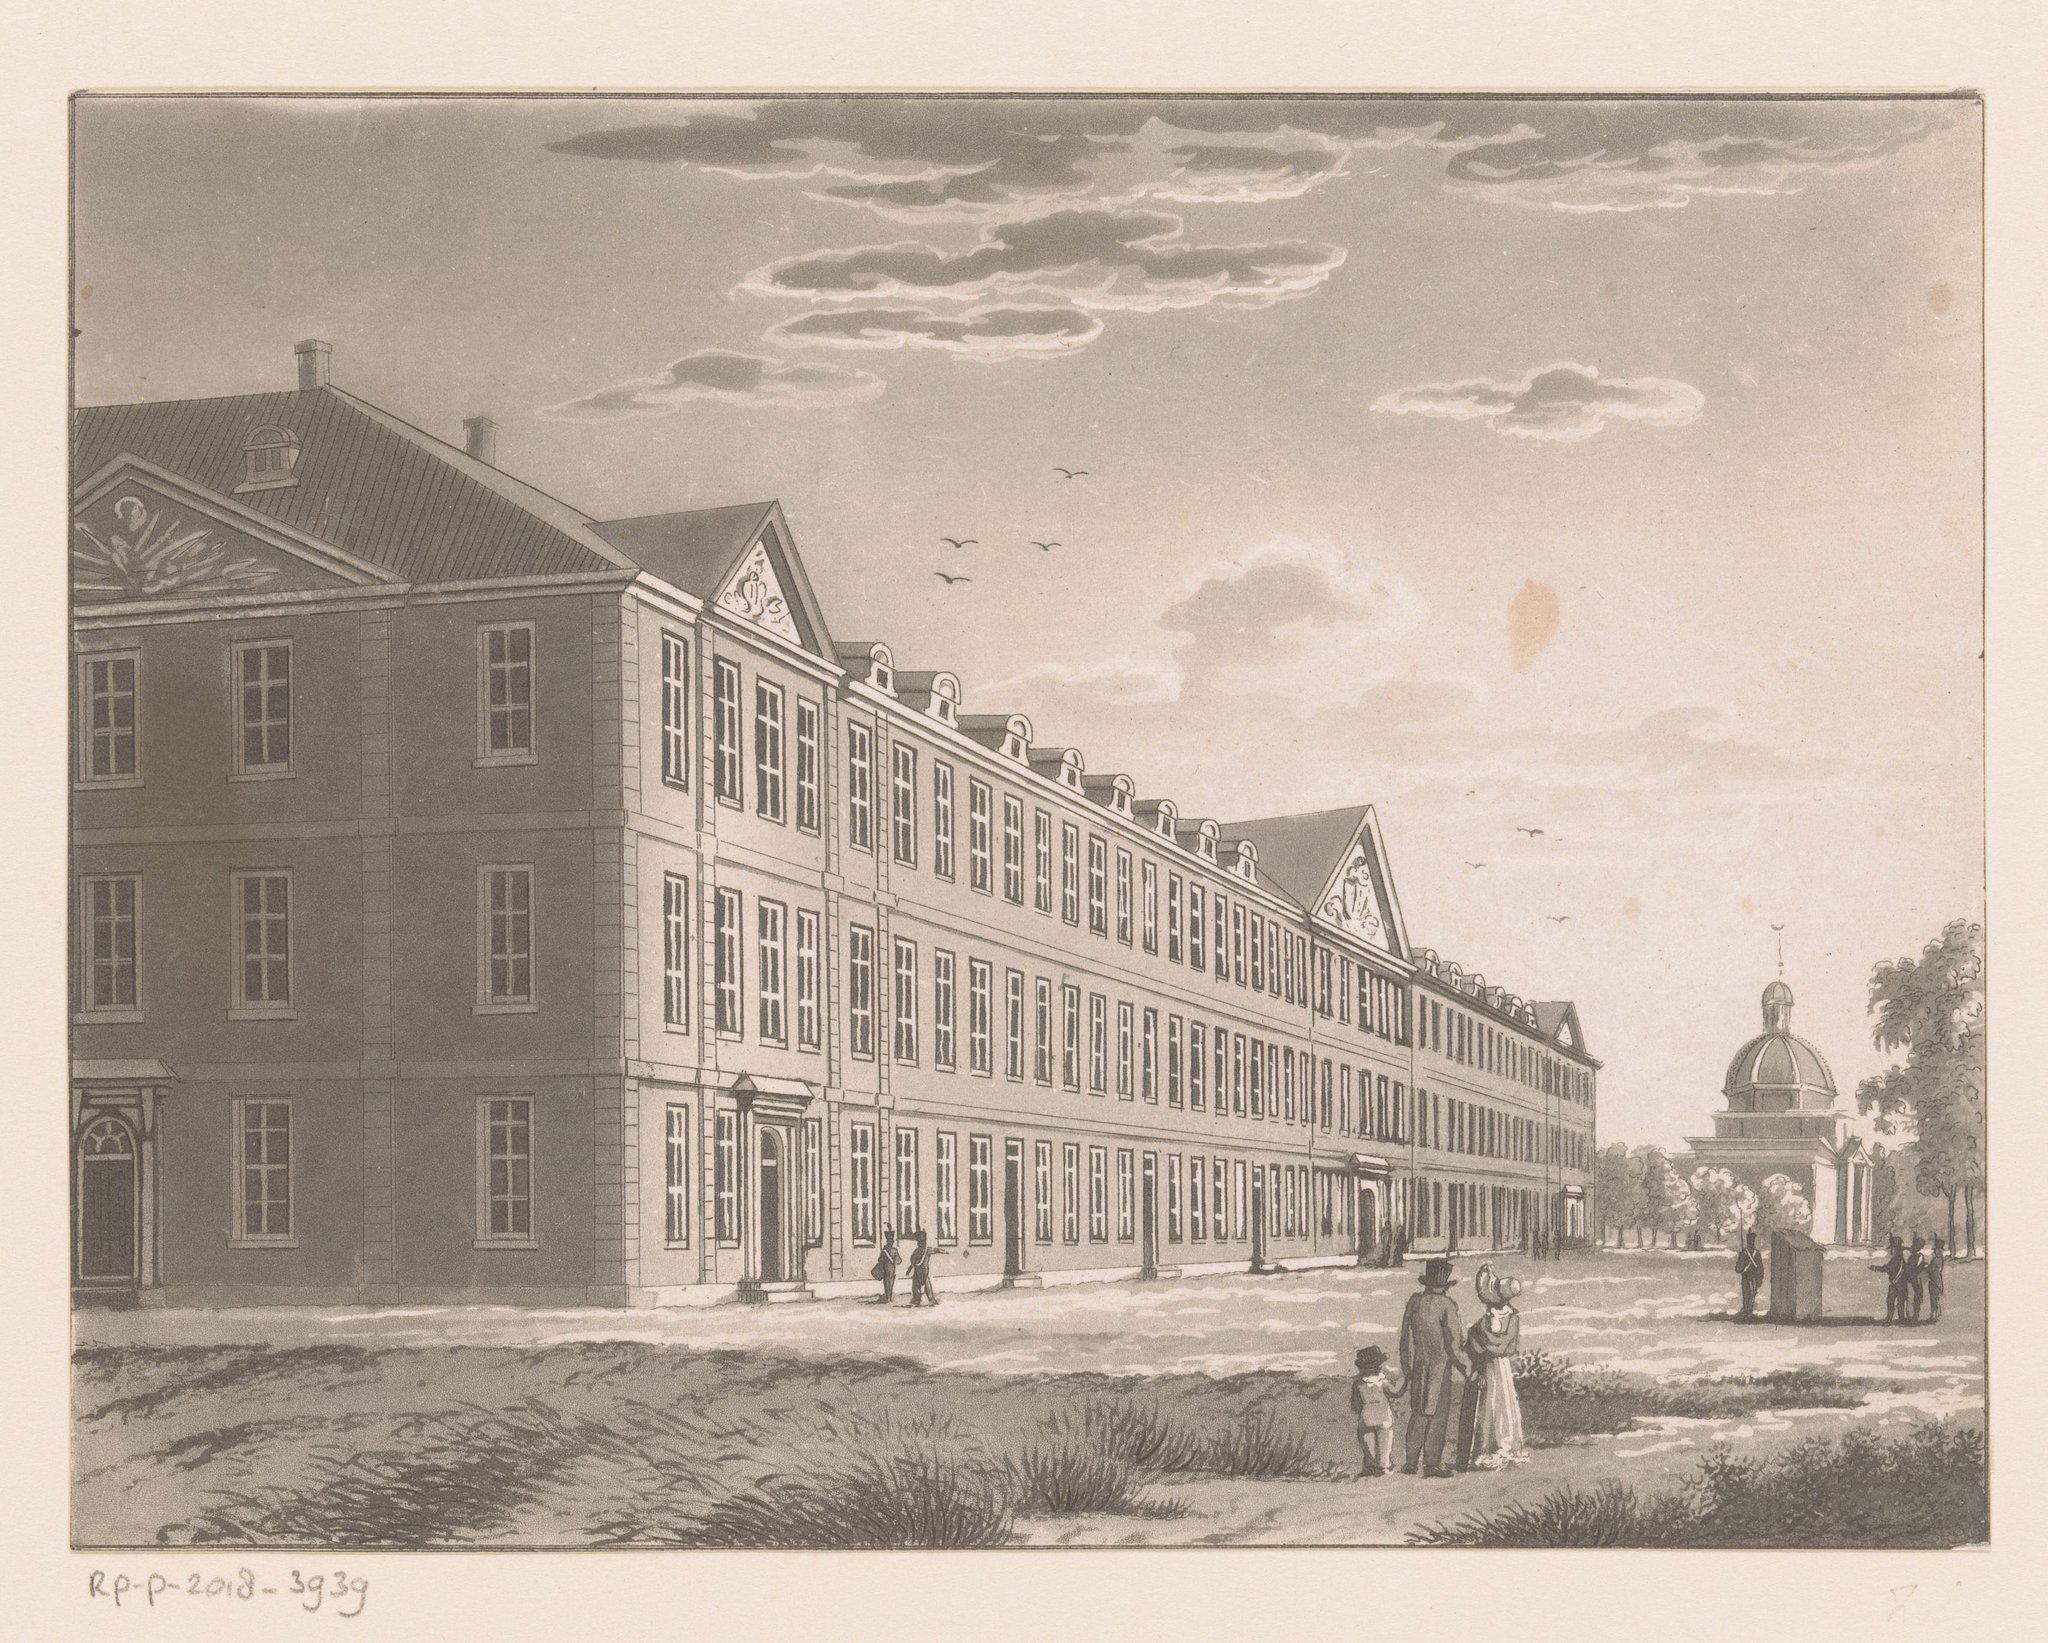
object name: print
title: Gezicht op de Oranje-Nassau Kazerne te Amsterdam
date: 1825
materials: paper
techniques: aquatint, etching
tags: barracks